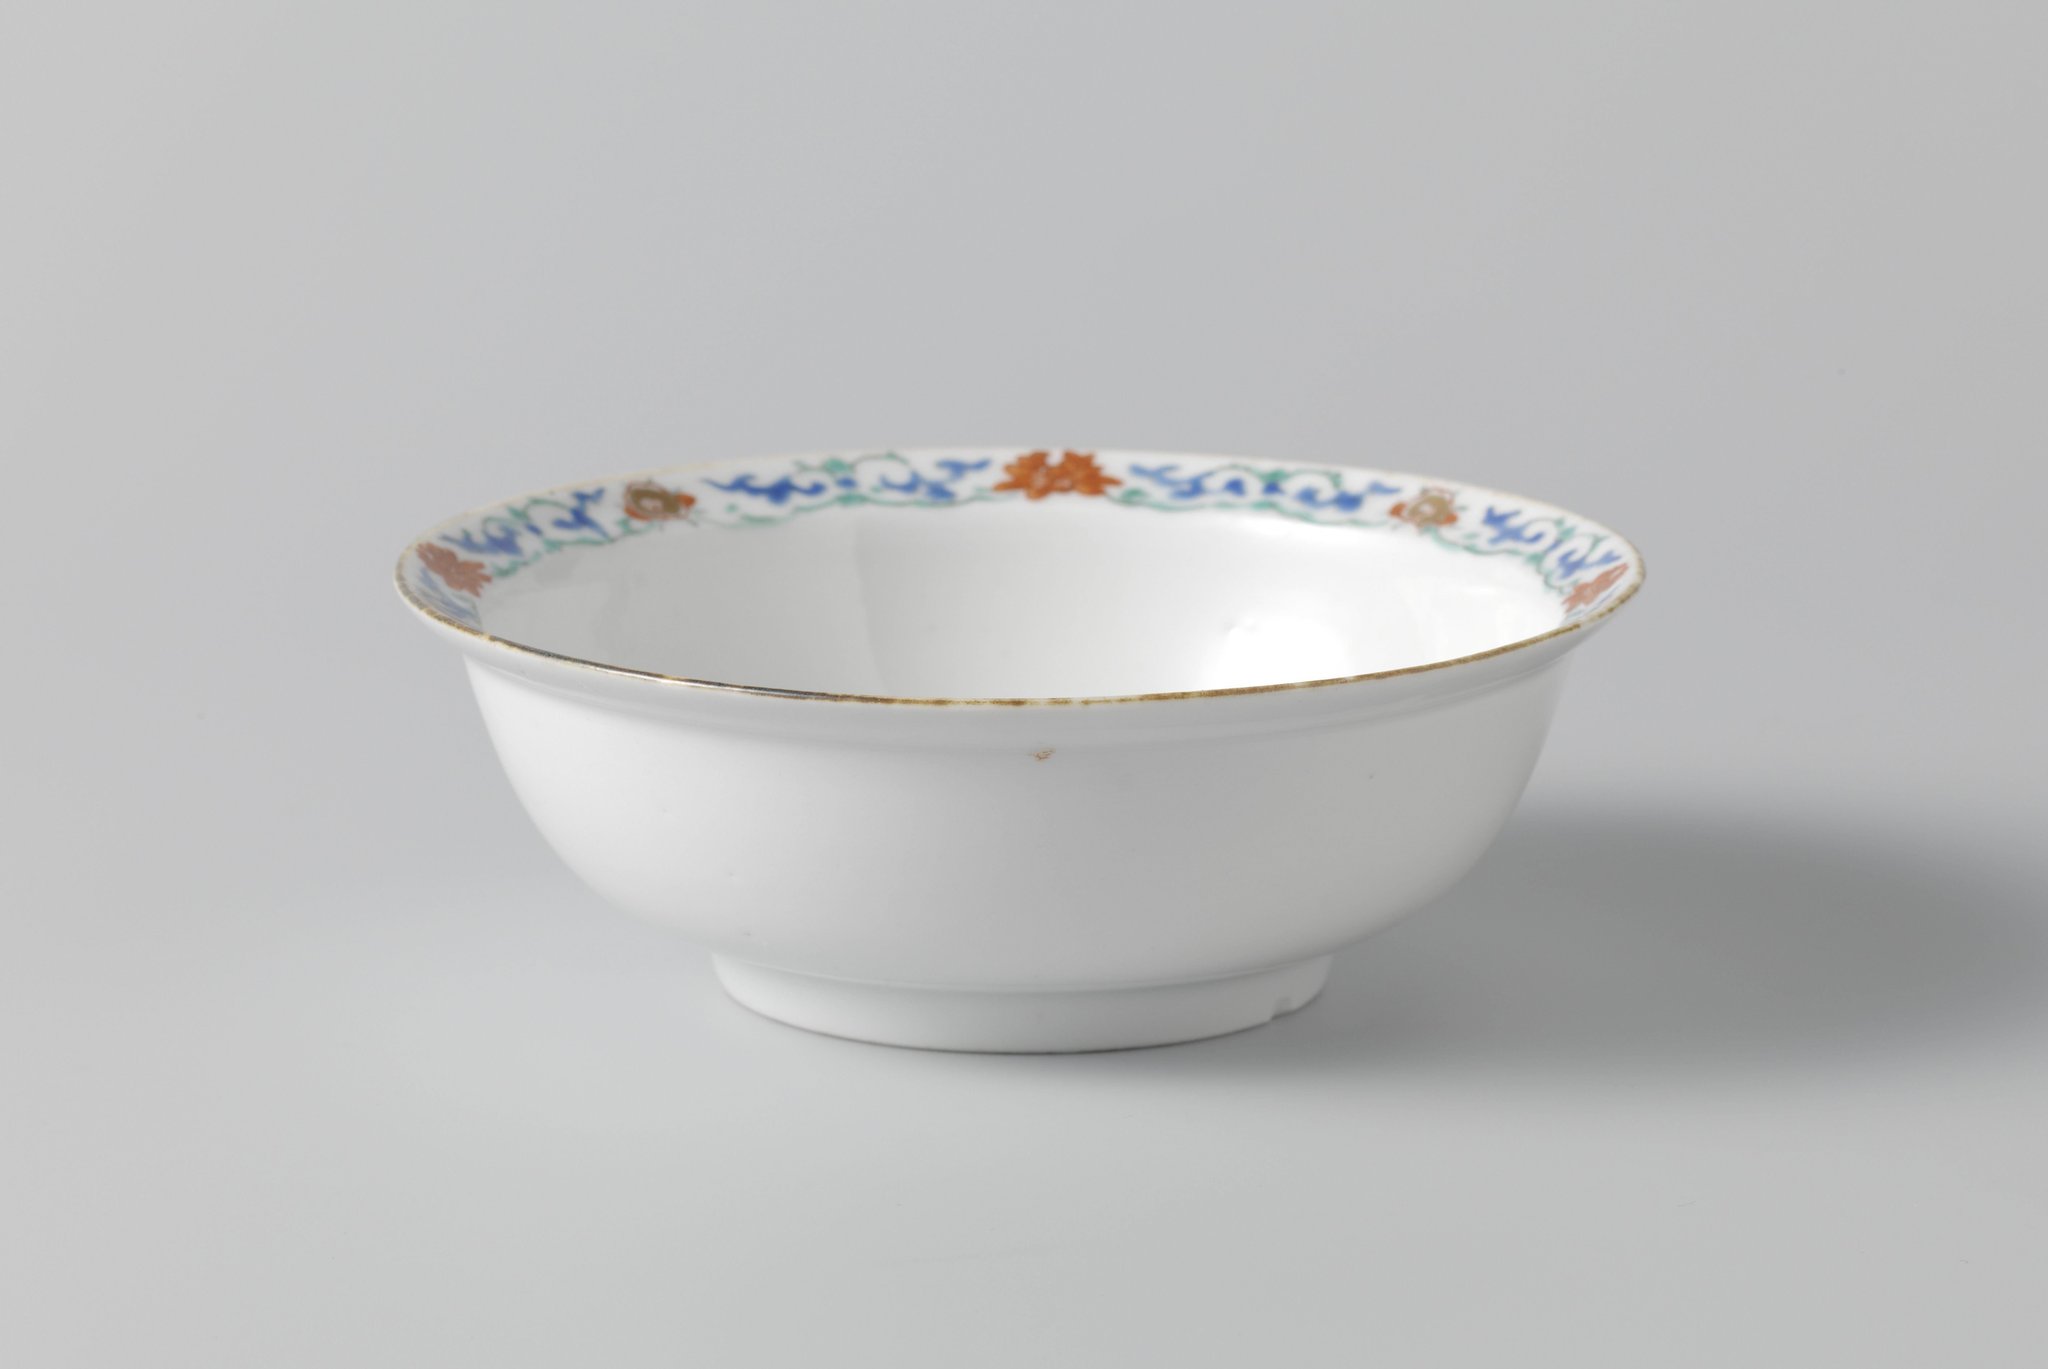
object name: bowl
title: Shallow bowl with prunus and pinetree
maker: Anonymous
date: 1670-1690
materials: glaze, gold, paint, porcelain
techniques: firing, gilding, turning, vitrification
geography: arita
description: AK-NM-6401 Twee ondiepe kommen • Japans gekleurd porselein – Kakiemon • Onderdeel van Royers porseleincollectie Dit is een vrij zeldzame vorm. Alleen in de Shobat-collectie vond ik precies deze vorm met dezelfde beschildering [Shibata Collectie 1997, vol V, nr. 90. P. 74]. Maar het decor in het plat komt veel voor [Jenyns 1965, pl. 77A, Hinton & Impey 1989. Nr. 28A], ook op Meissen-porselein uit de jaren ’20 en ’20 van de 18de eeuw, hetgeen wijst op de grote waardering op dat moment voor Kakiemon-porselein [Shono 1973, pl. 43 (bord) en 73 (terrine)]. Bronnen: Soame Jenyns, Japanese porcelain, Londen, 1965. Masako Shono, Japanisches Aritaporzellan im sogenannten "Kakiemonstil" als Vorbild für die Meissener Porzellanmanufaktur, München, 1973. Mark Hinton, Oliver Impey, Kakiemon porcelain from the English country house: flowers of fire, Londen, 1989. Shibata Collection (cat. Kyushu Ceramic Museum). Kyushu, 1991-1998.